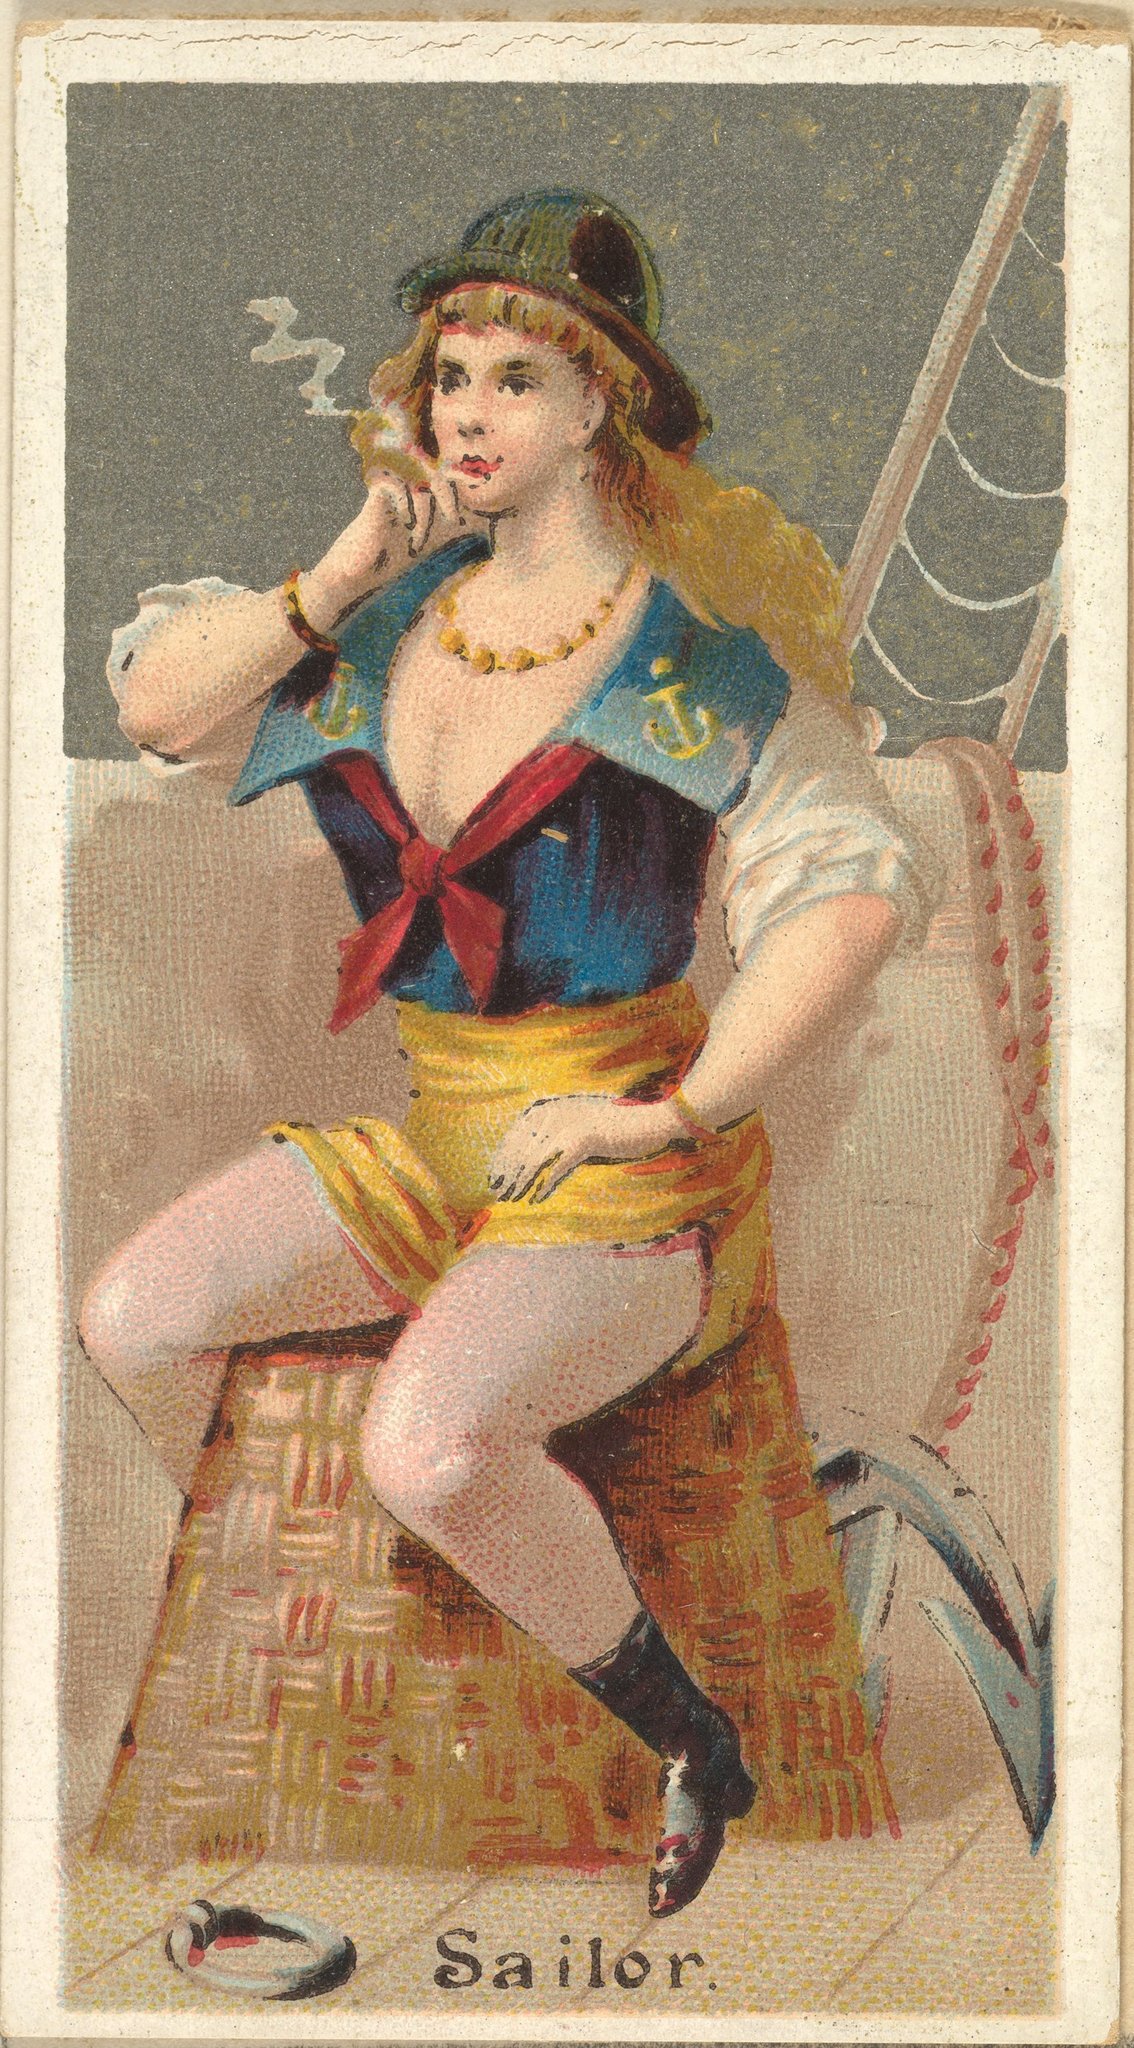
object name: print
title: Sailor, from the Occupations for Women series (N166) for Old Judge and Dogs Head Cigarettes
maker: goodwin & company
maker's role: publisher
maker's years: 1850-1950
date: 1887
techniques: color lithograph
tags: women,smoking,sailors